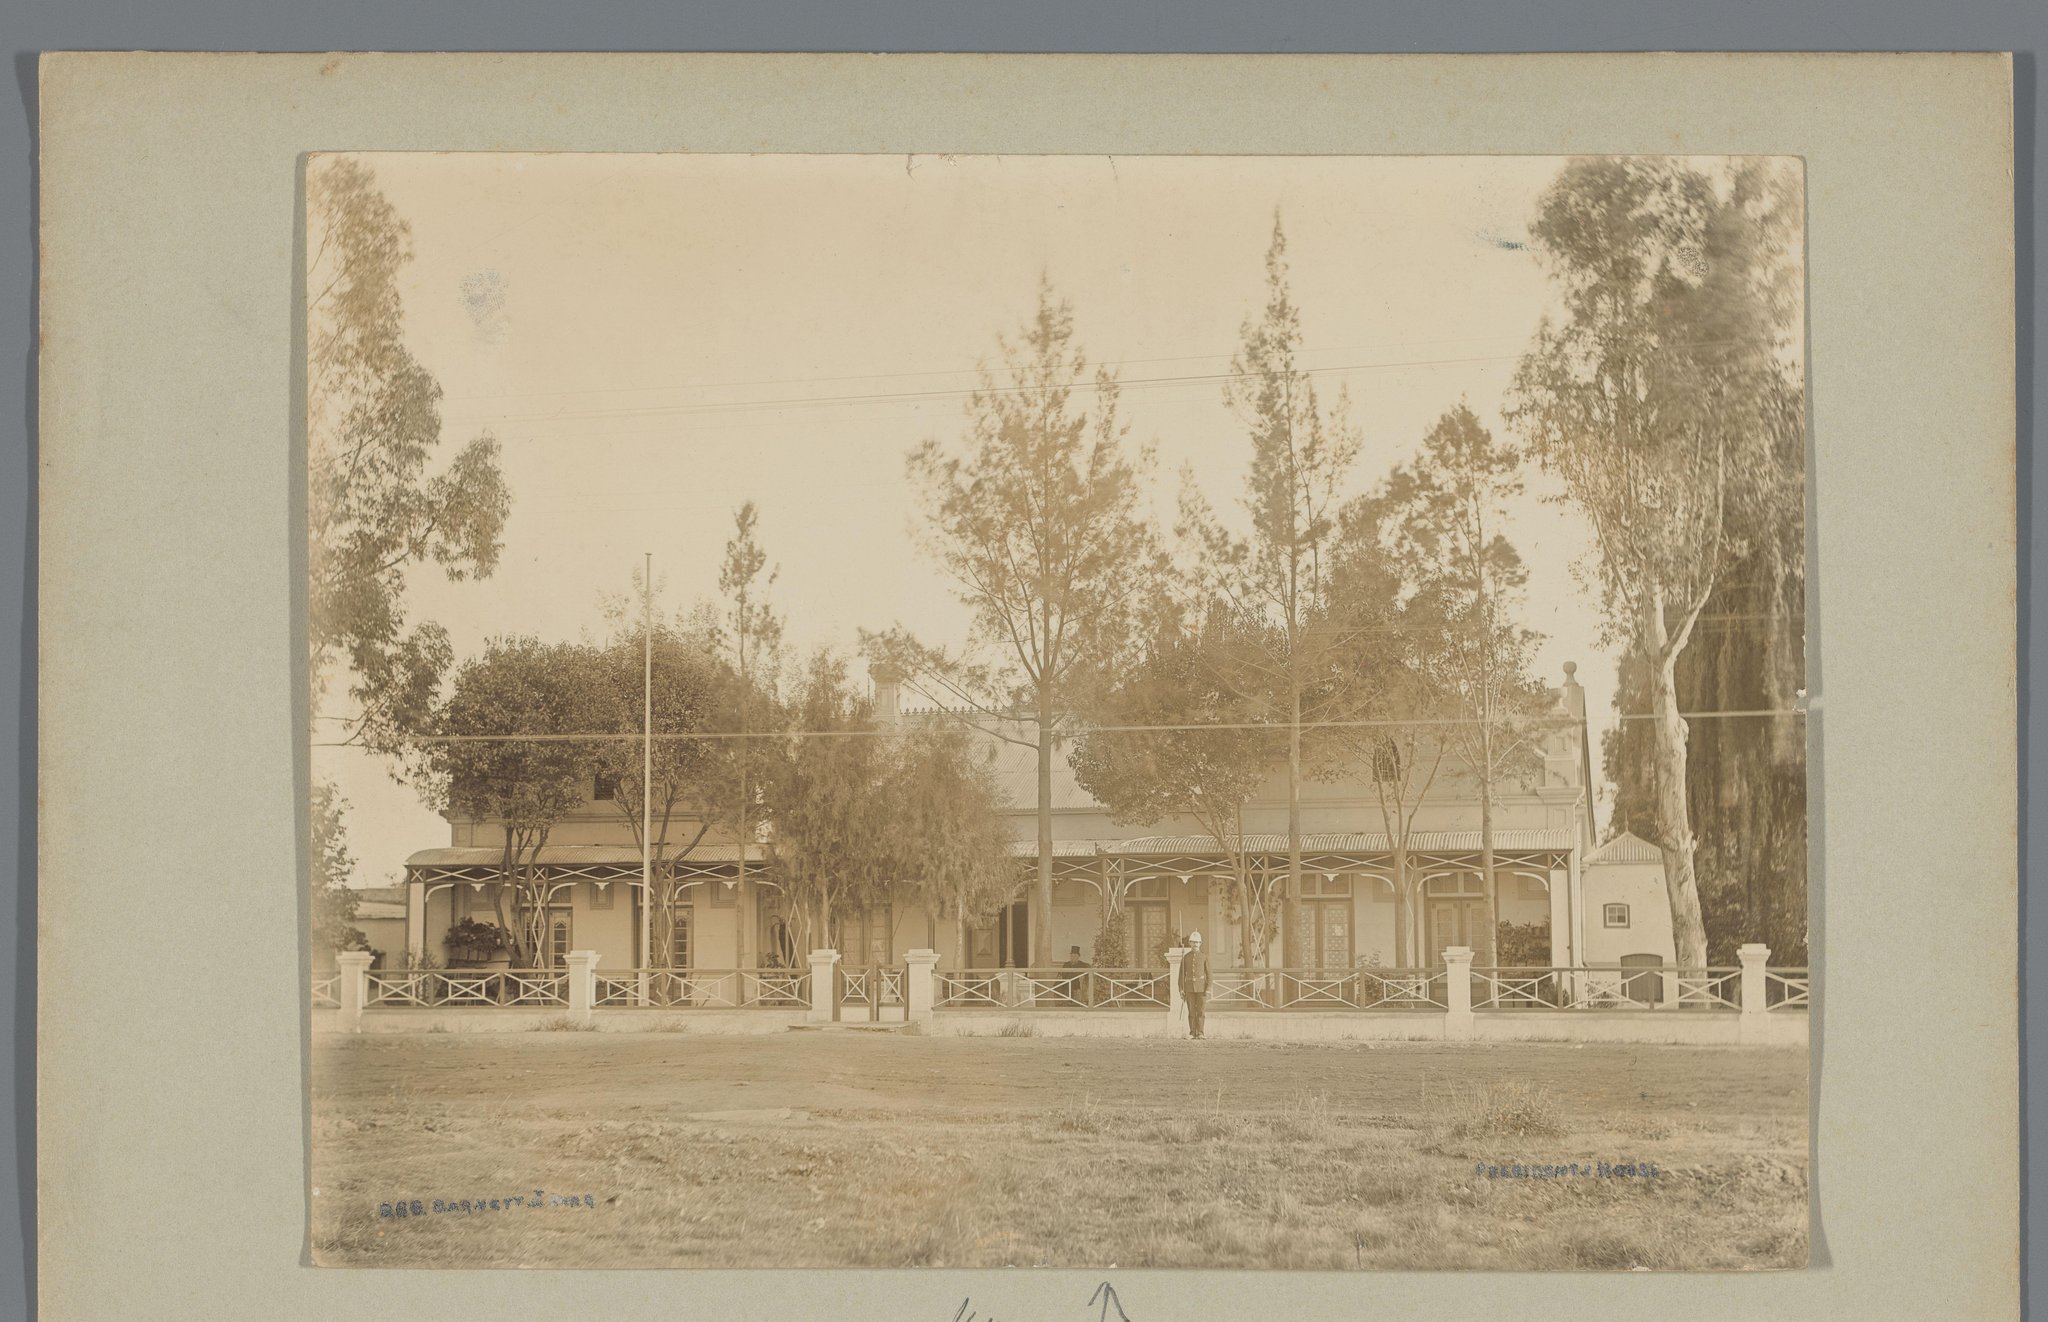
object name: photograph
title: Krugerhuis in Pretoria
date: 1890-1905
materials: paper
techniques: gelatin silver print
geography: pretoria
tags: exterior ~ representation of a building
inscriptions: inscription: ‘Kruger’